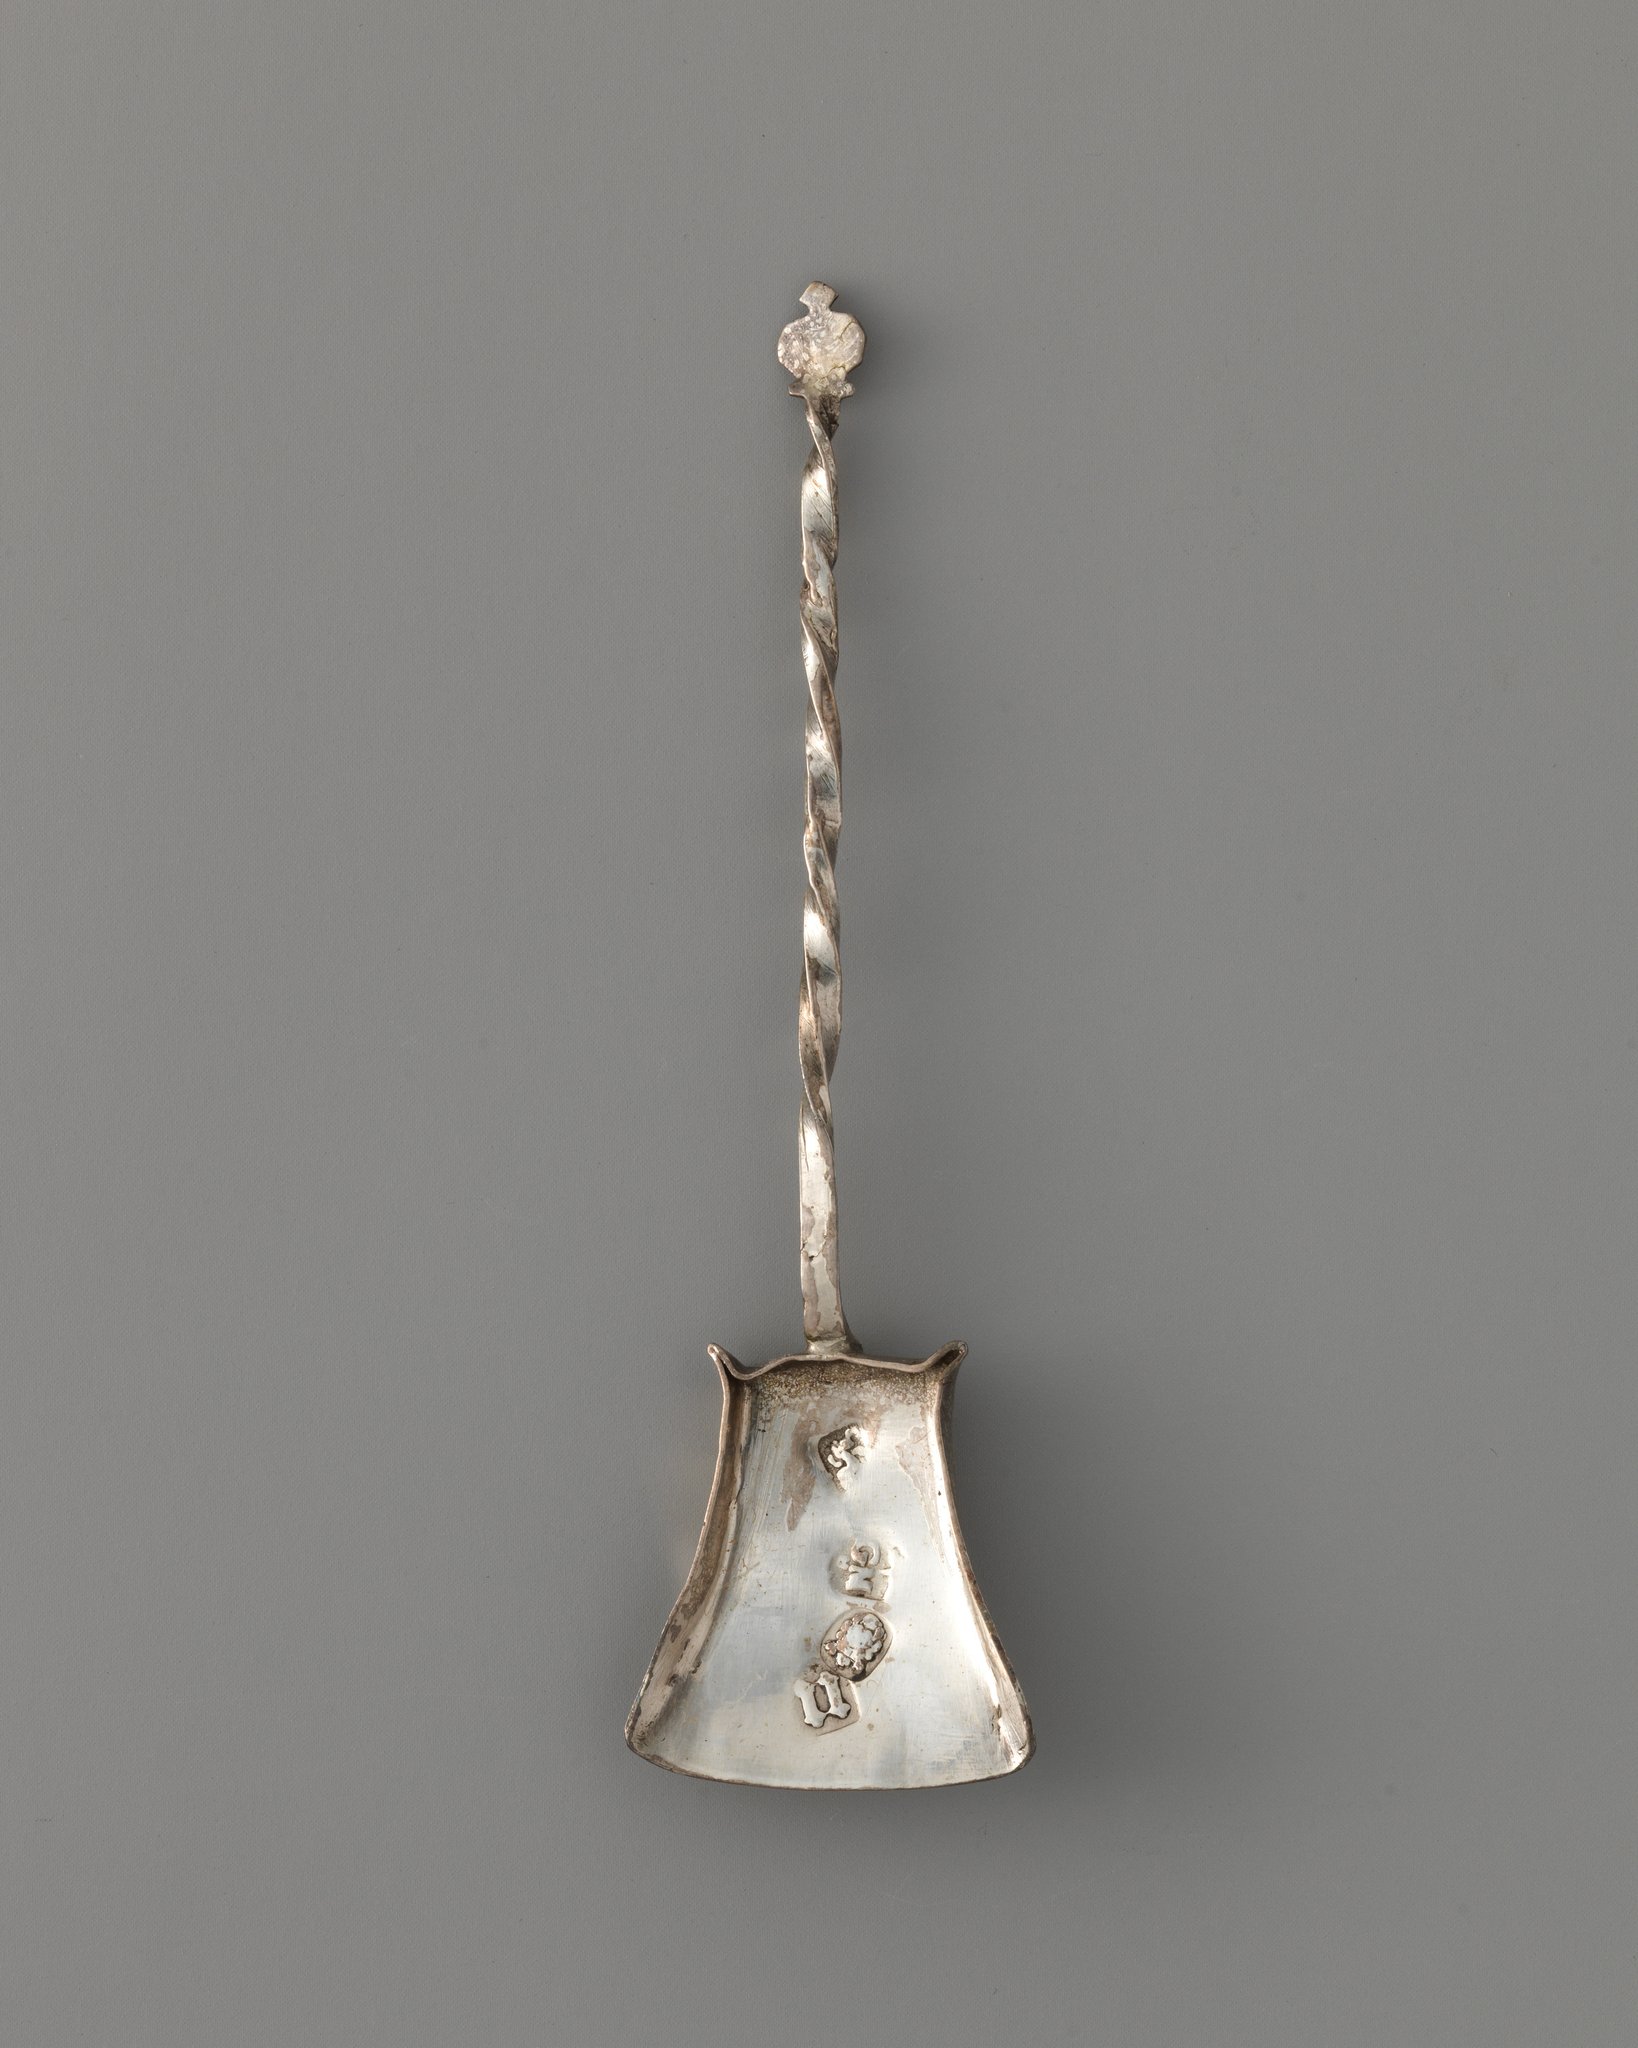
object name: shovel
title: Miniature shovel (part of a set)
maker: george manjoy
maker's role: maker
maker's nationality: british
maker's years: 1685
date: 1690-1691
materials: silver